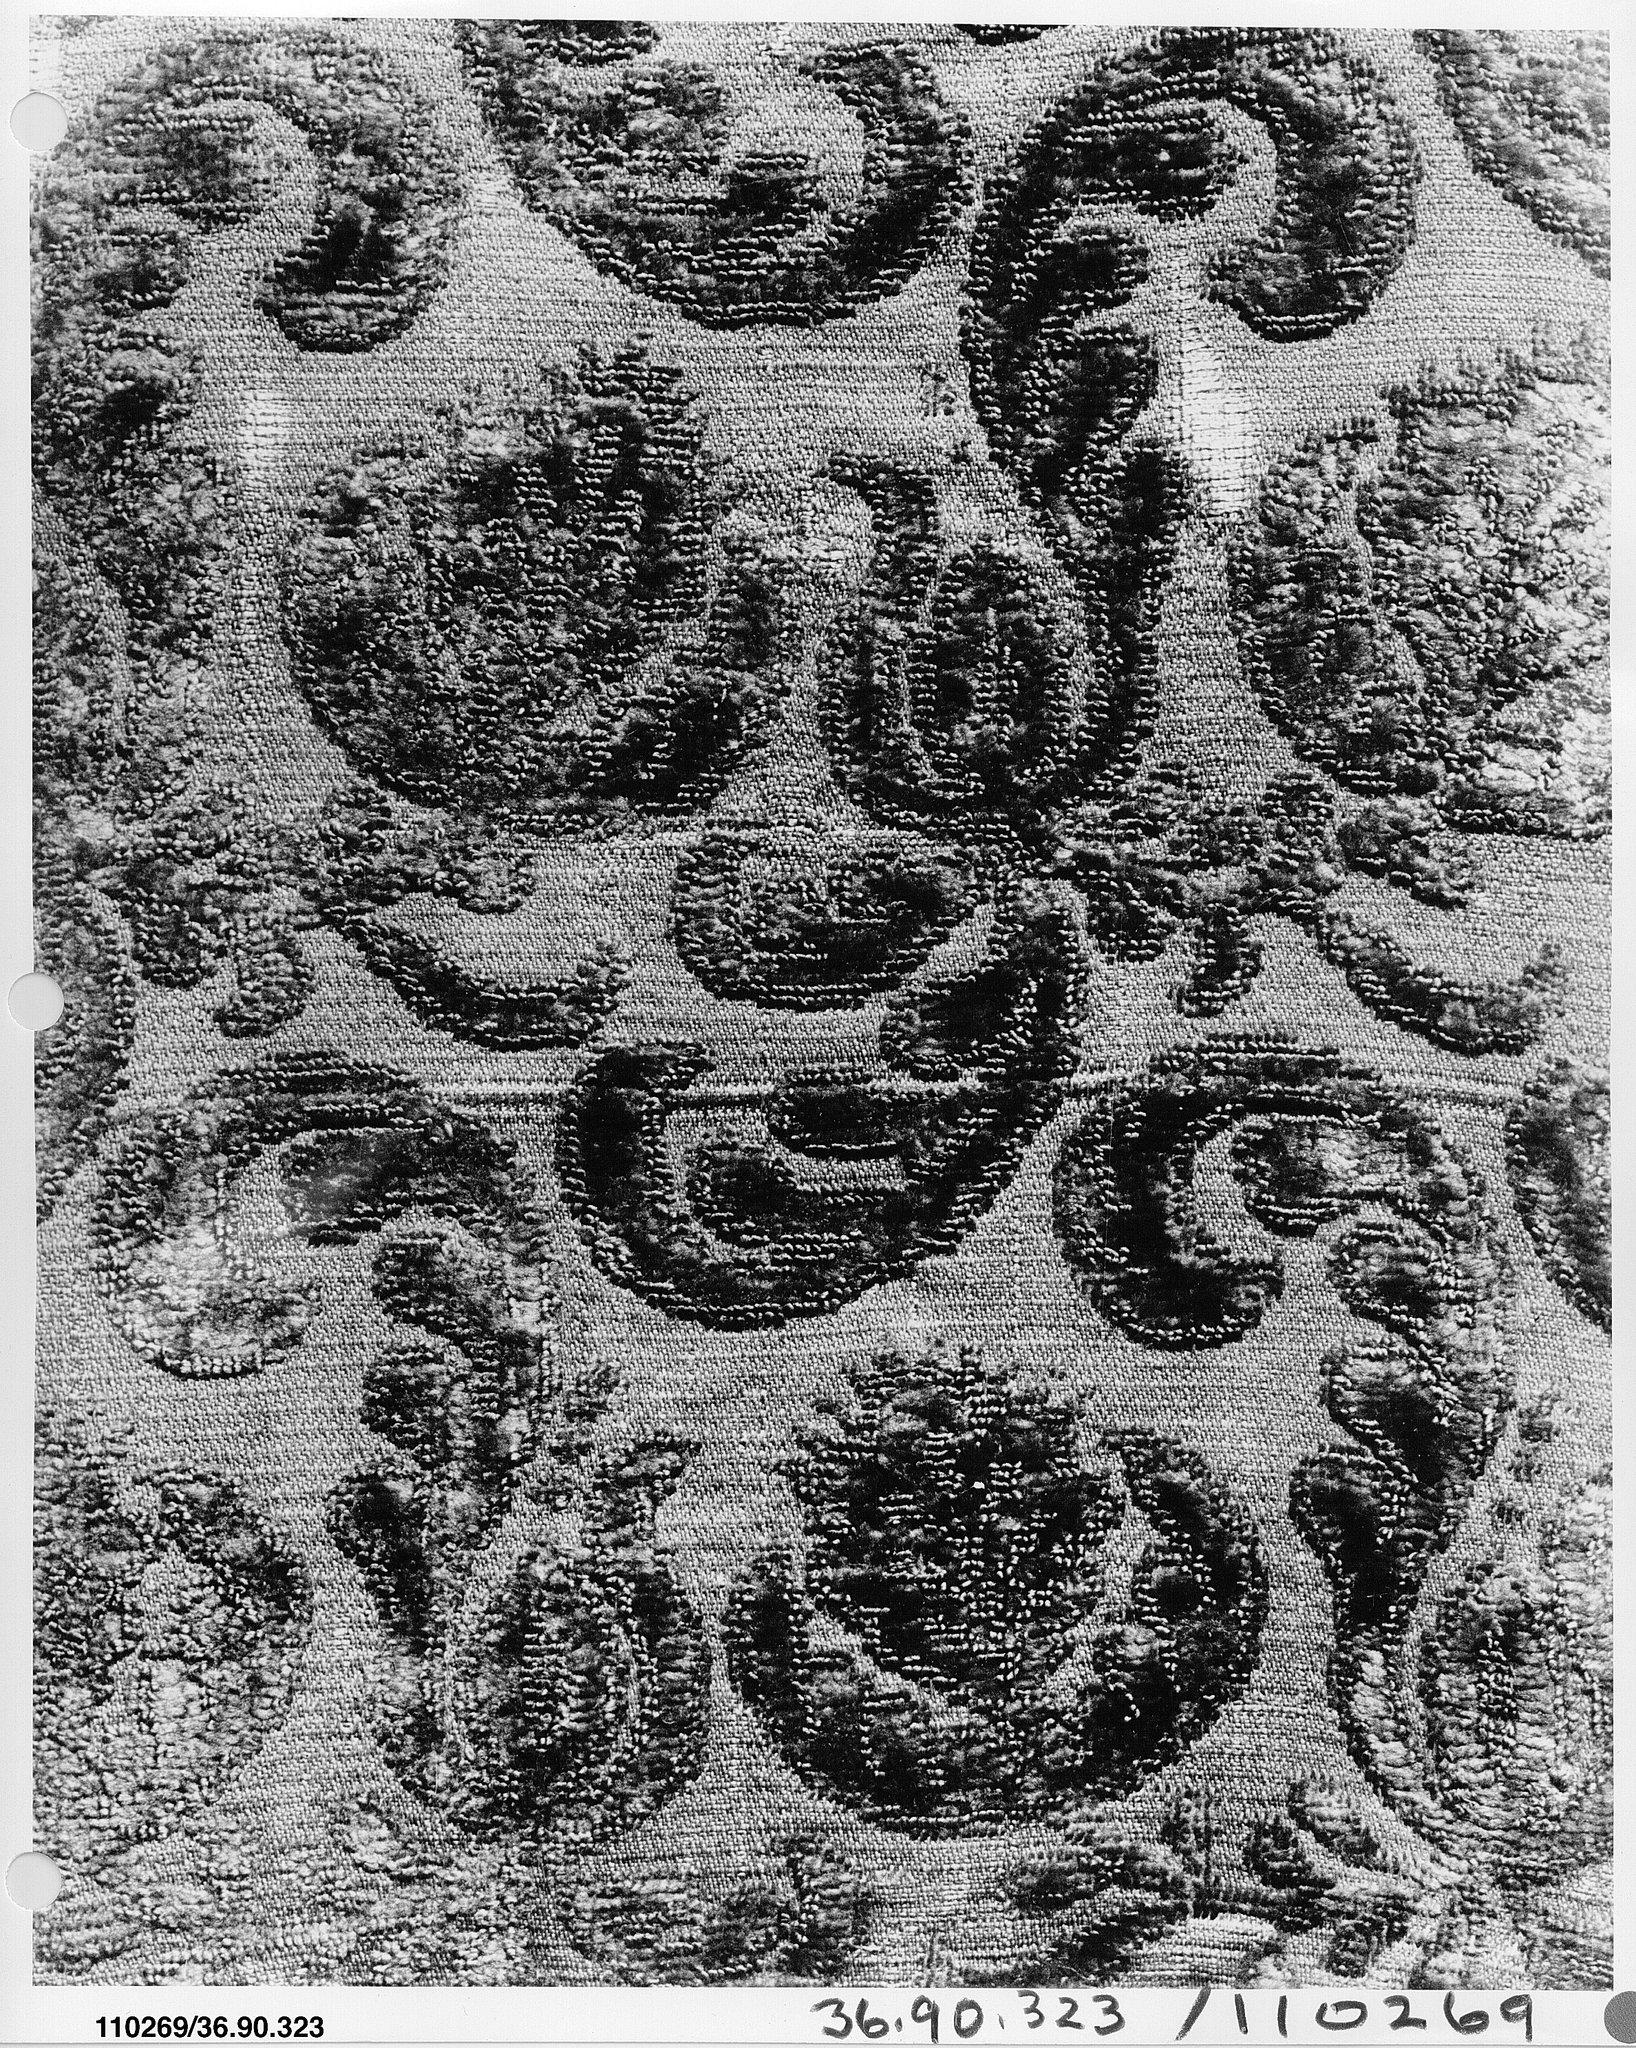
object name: piece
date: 1501-1700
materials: silk